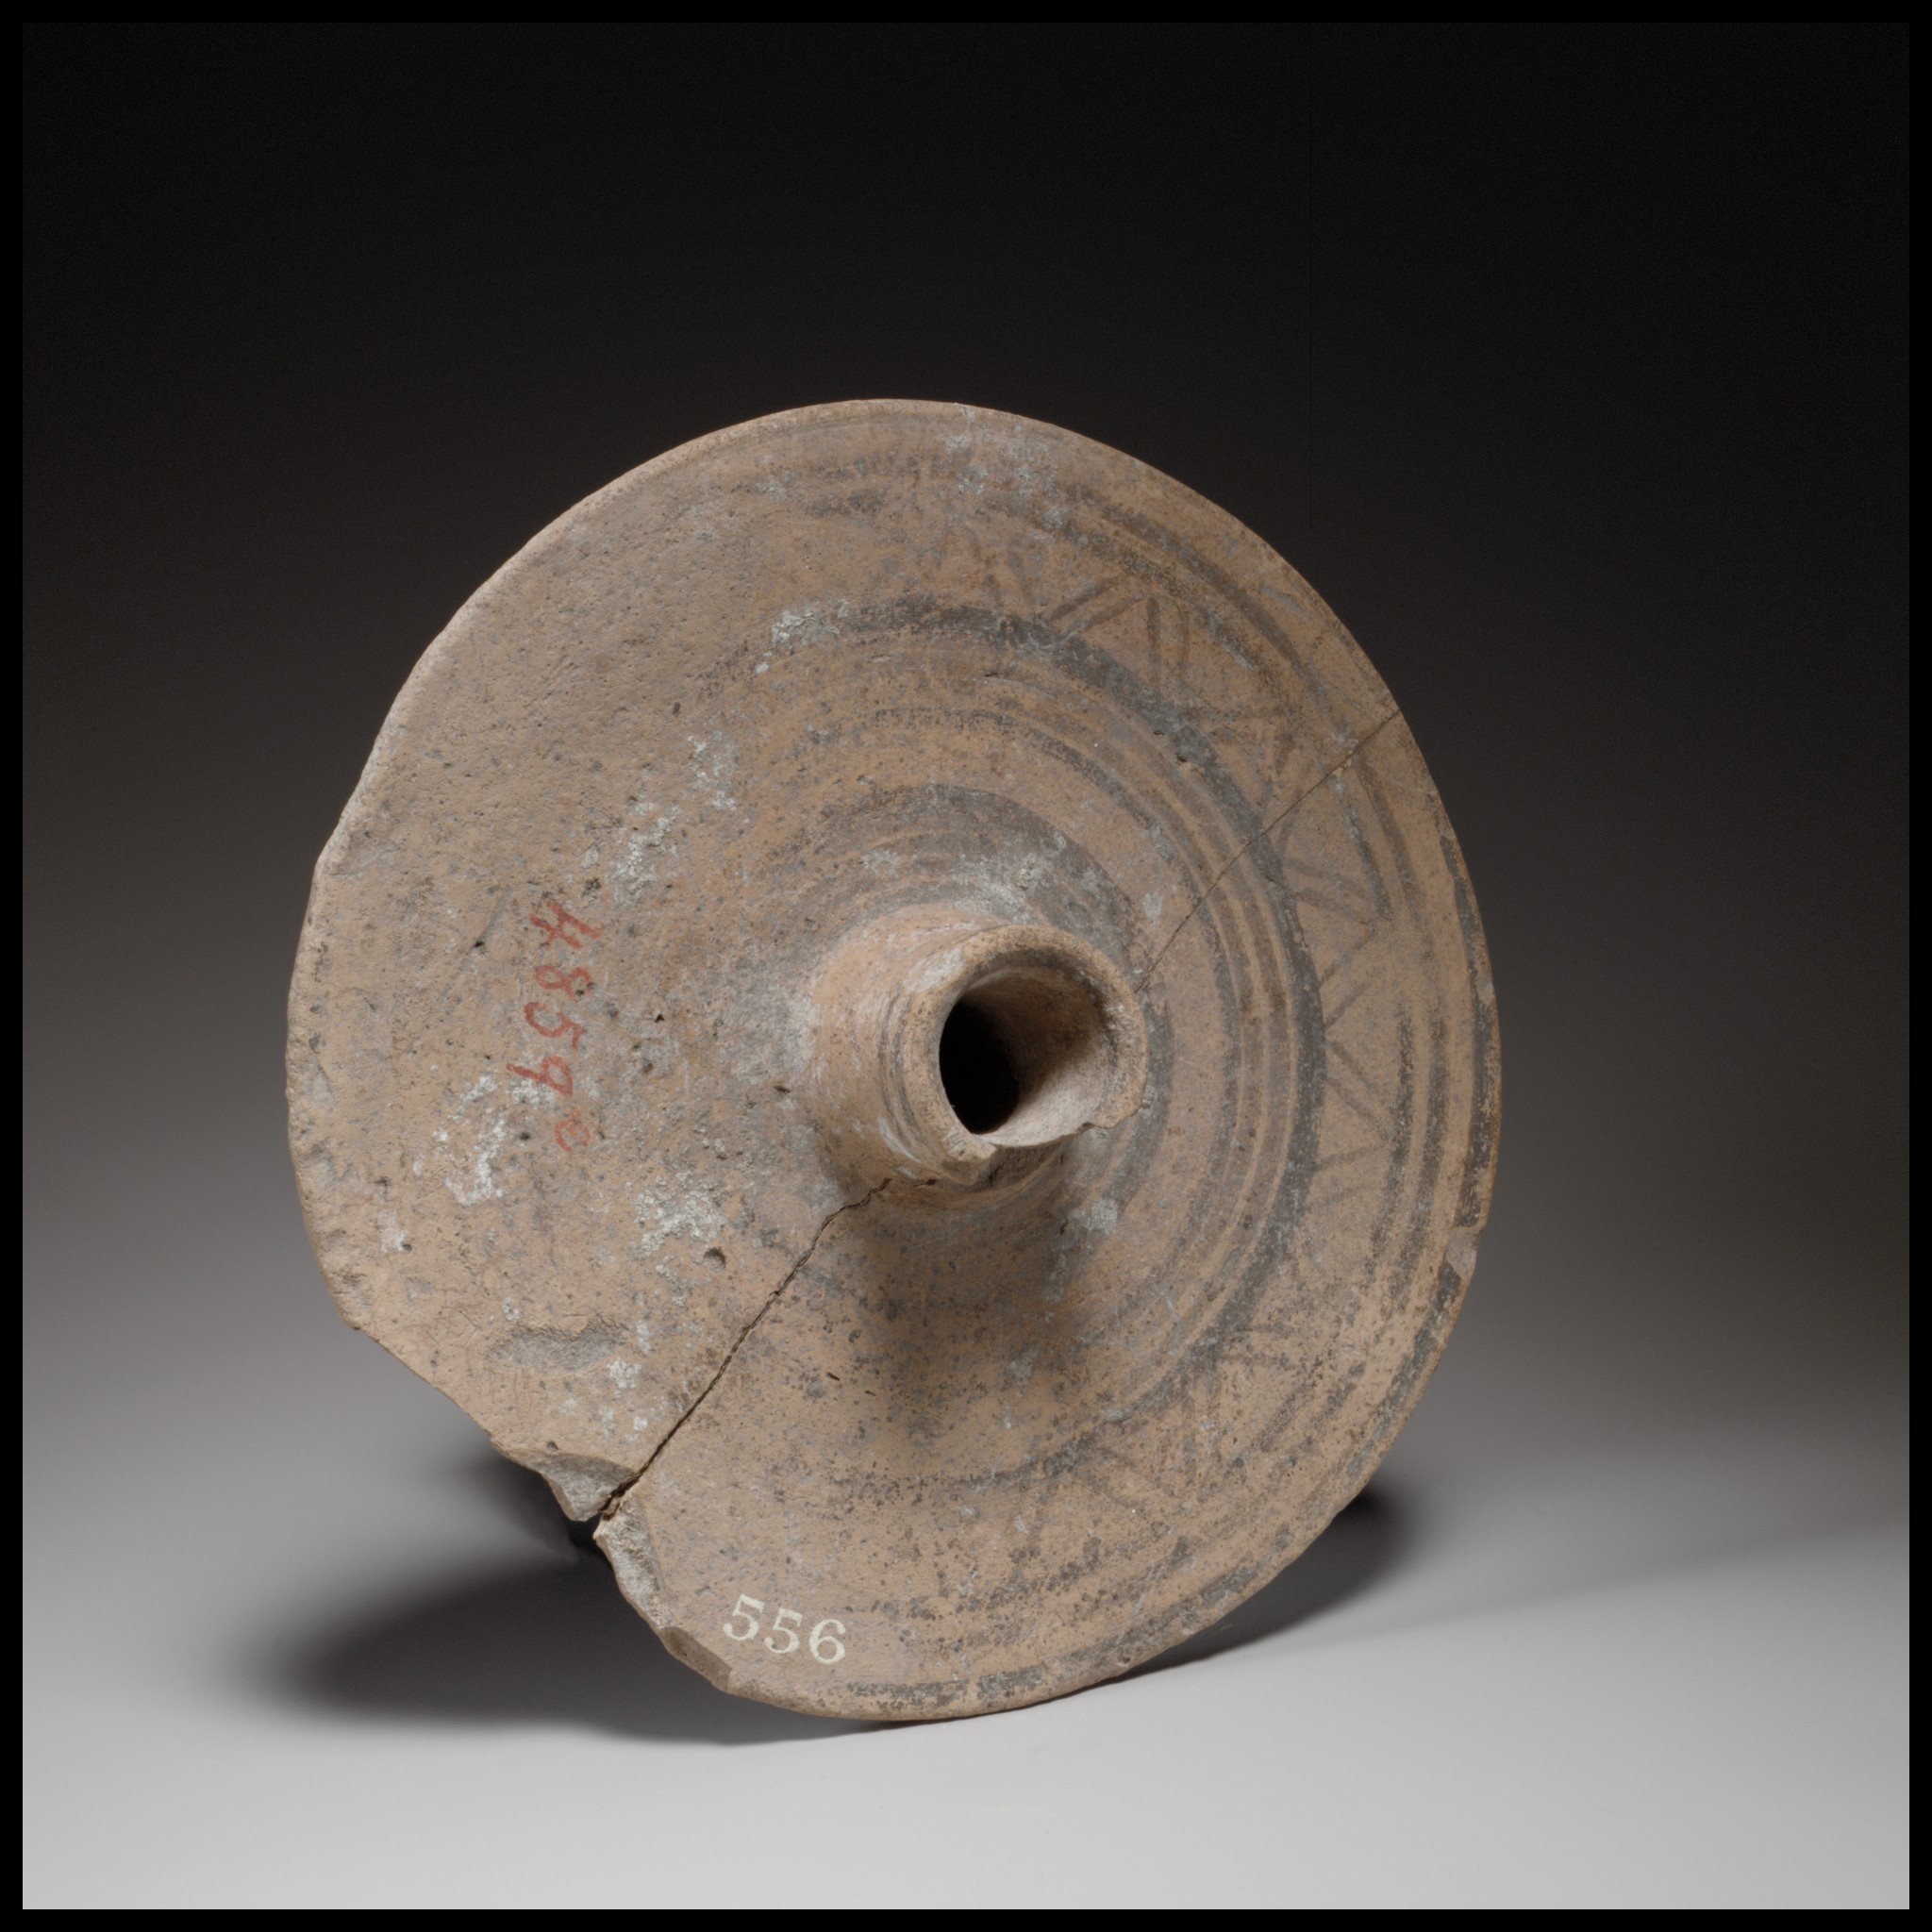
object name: chariot wheel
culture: cypriot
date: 750-600 BCE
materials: terracotta